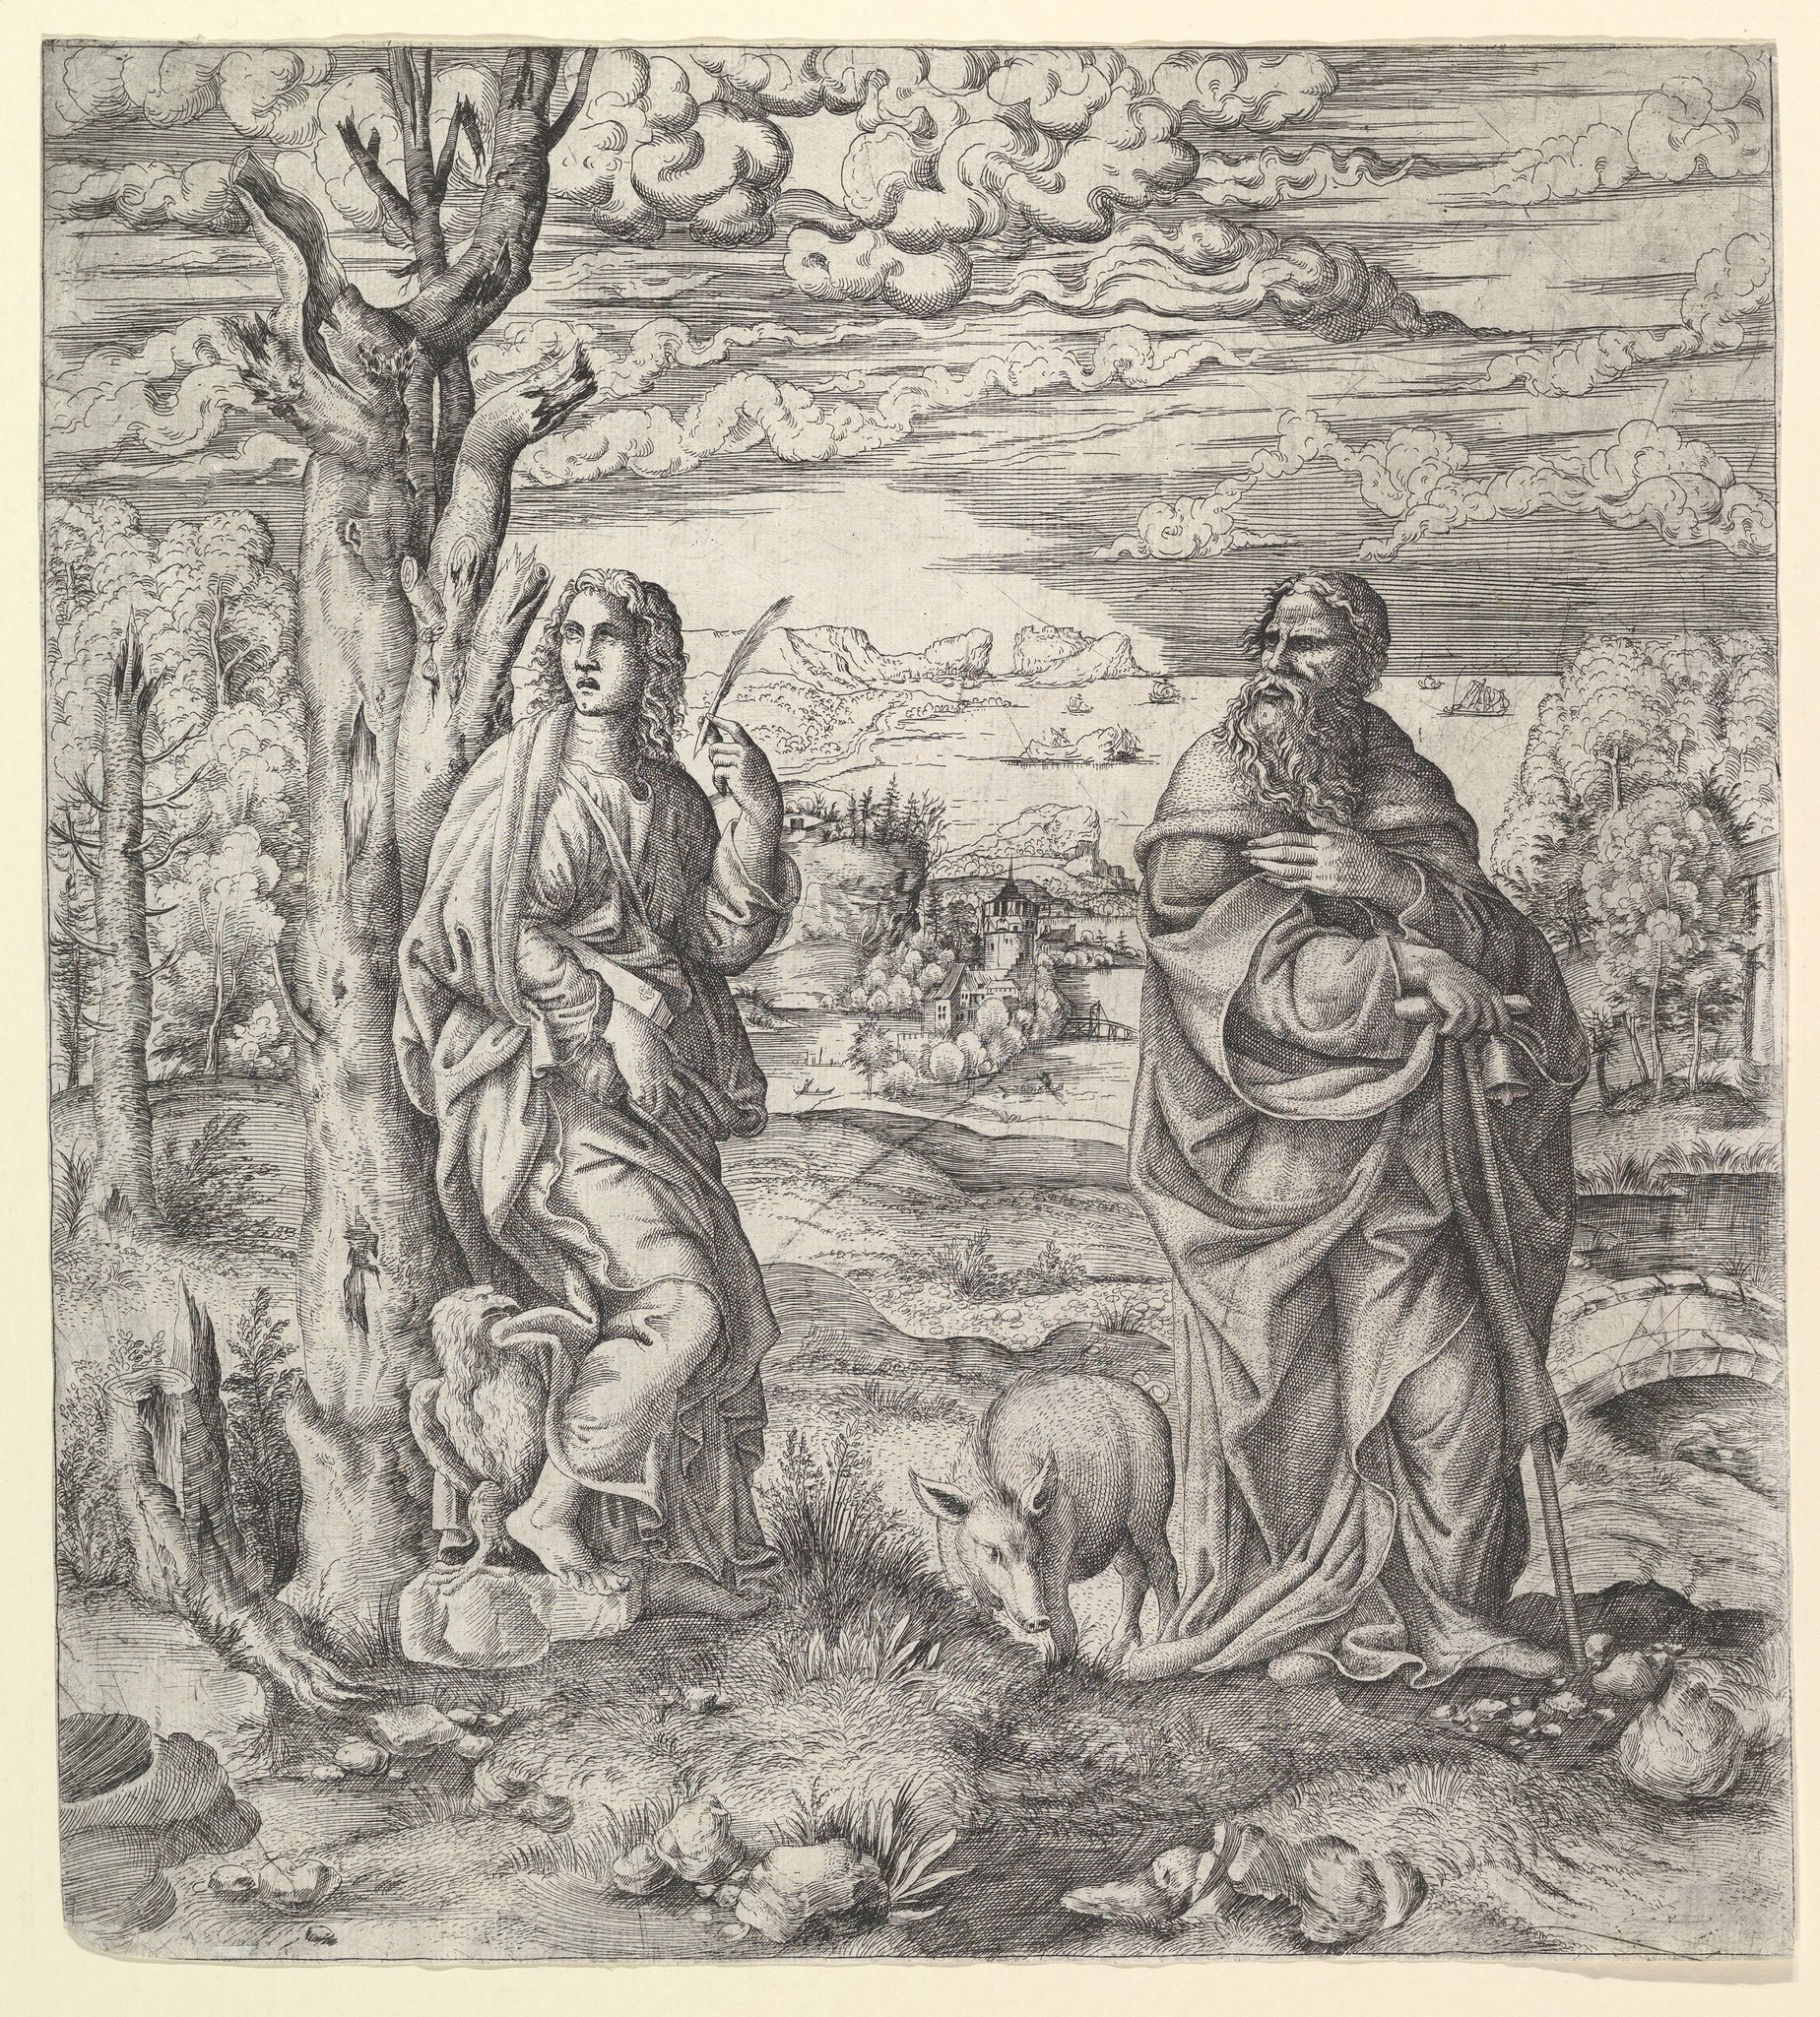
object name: print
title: Saint John and Anthony in a Landscape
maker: master iqv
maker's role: artist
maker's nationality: french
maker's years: 1500-1600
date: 1544-1545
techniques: etching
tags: animals,trees,saint anthony,saint john the baptist